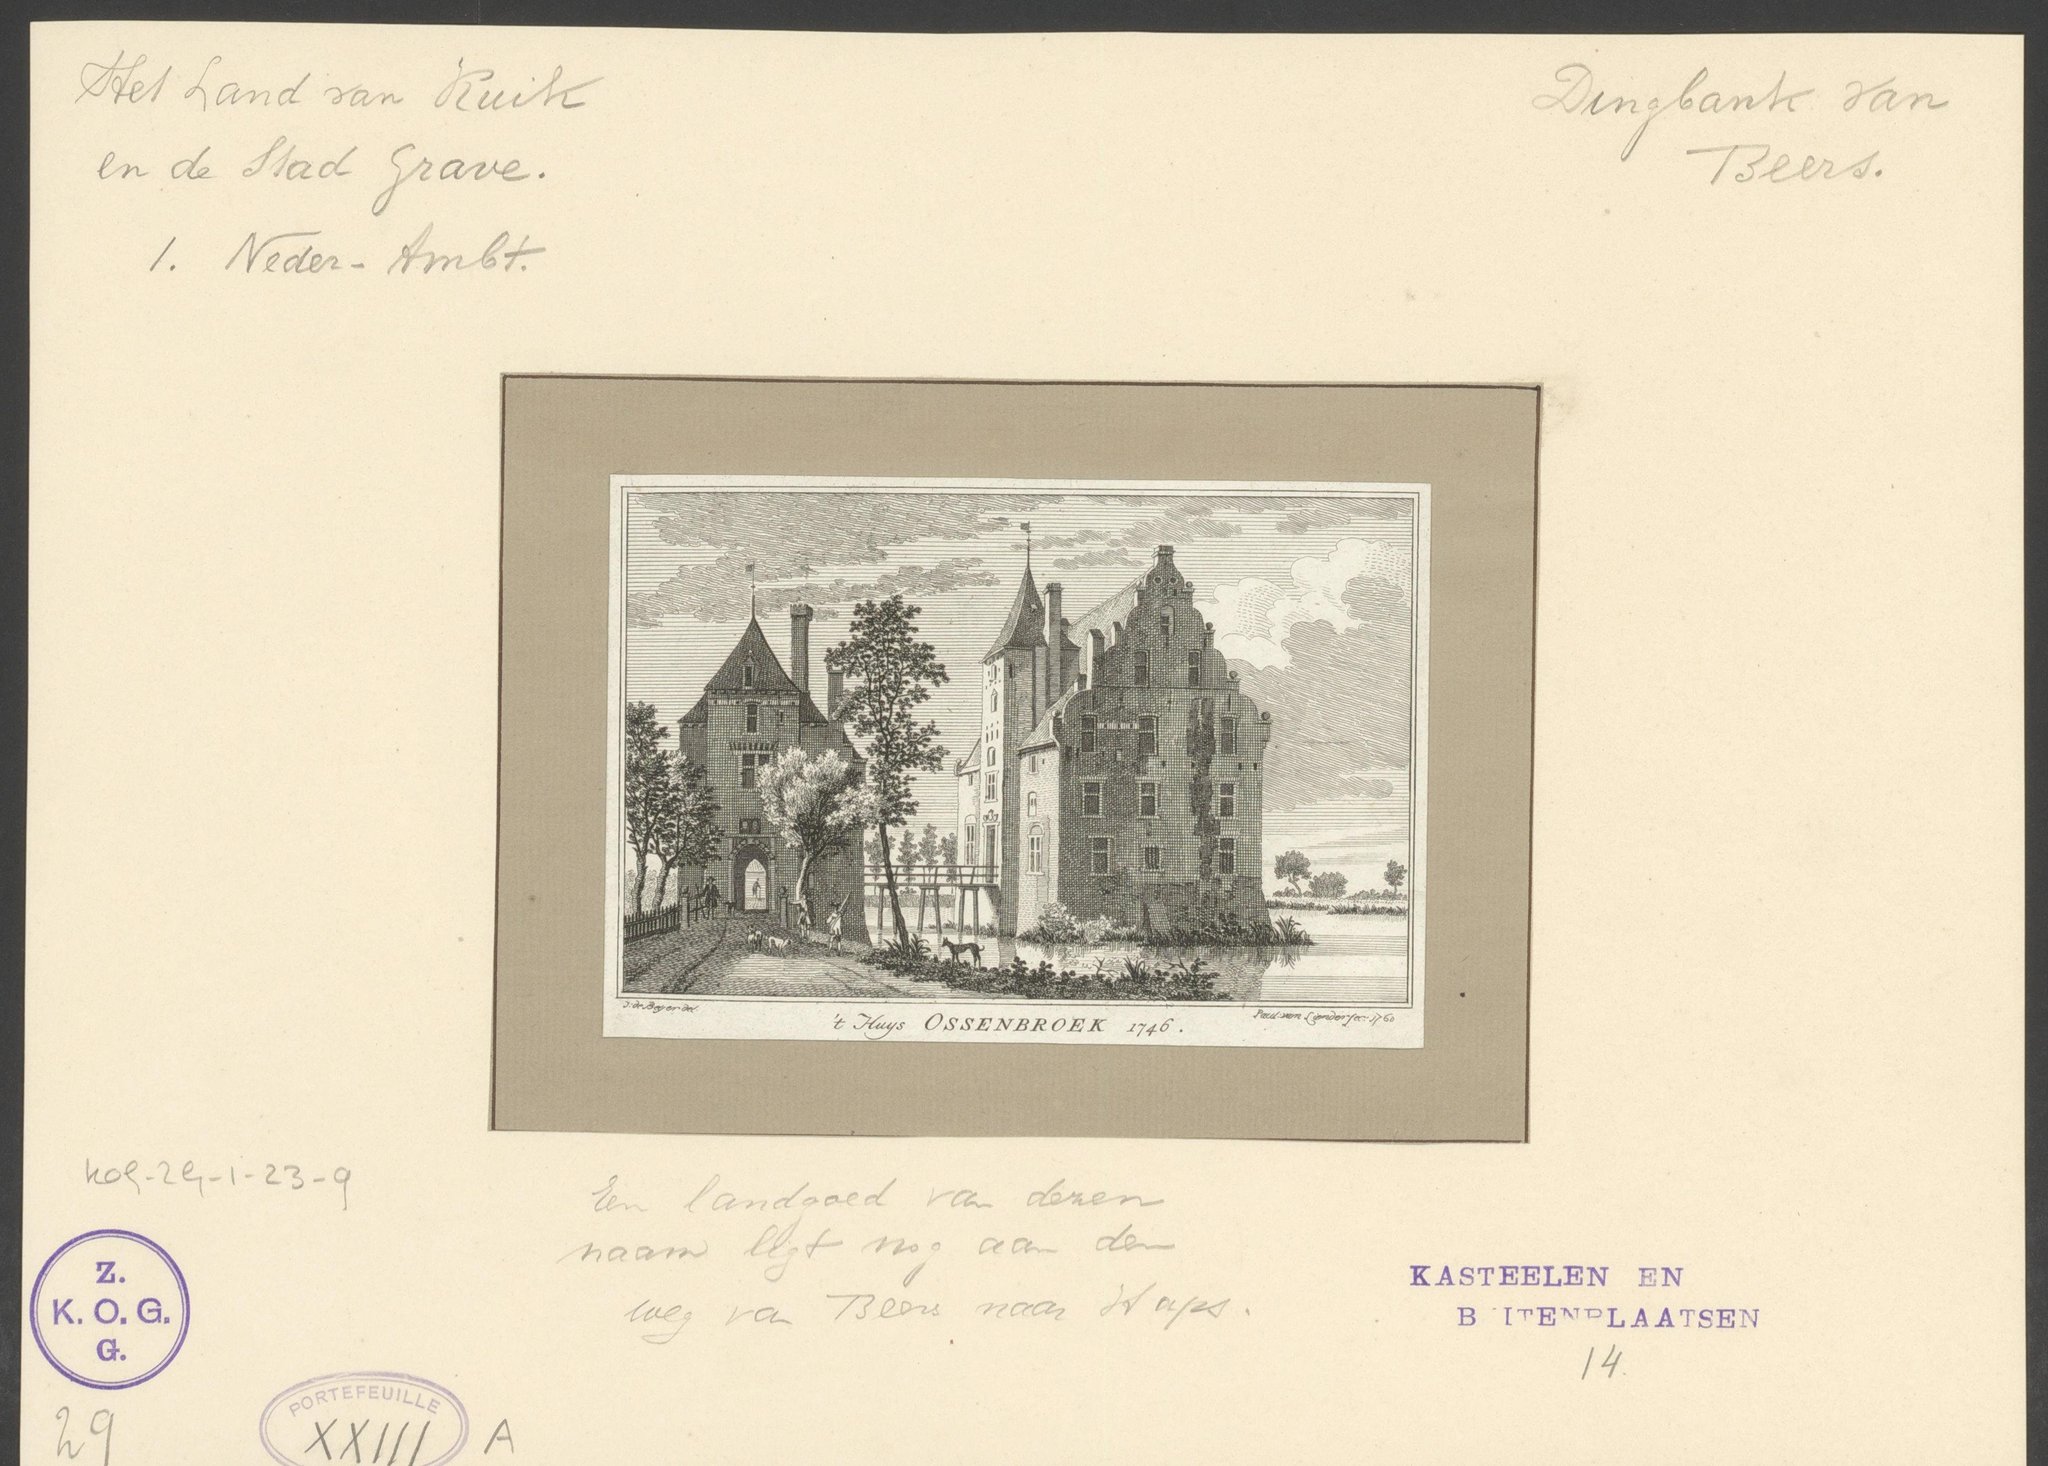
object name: print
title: Gezicht op het huis Ossenbroek bij Kleef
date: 1760-1792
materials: paper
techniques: engraving, etching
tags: abbey, monastery, convent ~ roman catholic church, ruin of a dwelling, house, castle, etc., cleves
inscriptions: stamp, collector's mark: Lugt 1641, stamp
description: Prent mogelijk uit: Het verheerlykt Nederland of kabinet van hedendaagsche gezigten van steden, dorpen (…). 9 dln. Amsterdam: Isaak Tirion en weduwe Isaak Tirion, 1745-1774, (1762). Of uit: Nederlandsche tafereelen; of eene keurige verzameling van negen honderd fraaije gezigten van steden, dorpen, sloten, oudheden (….). 9 dln. Amsterdam: Jan de Groot, 1792.